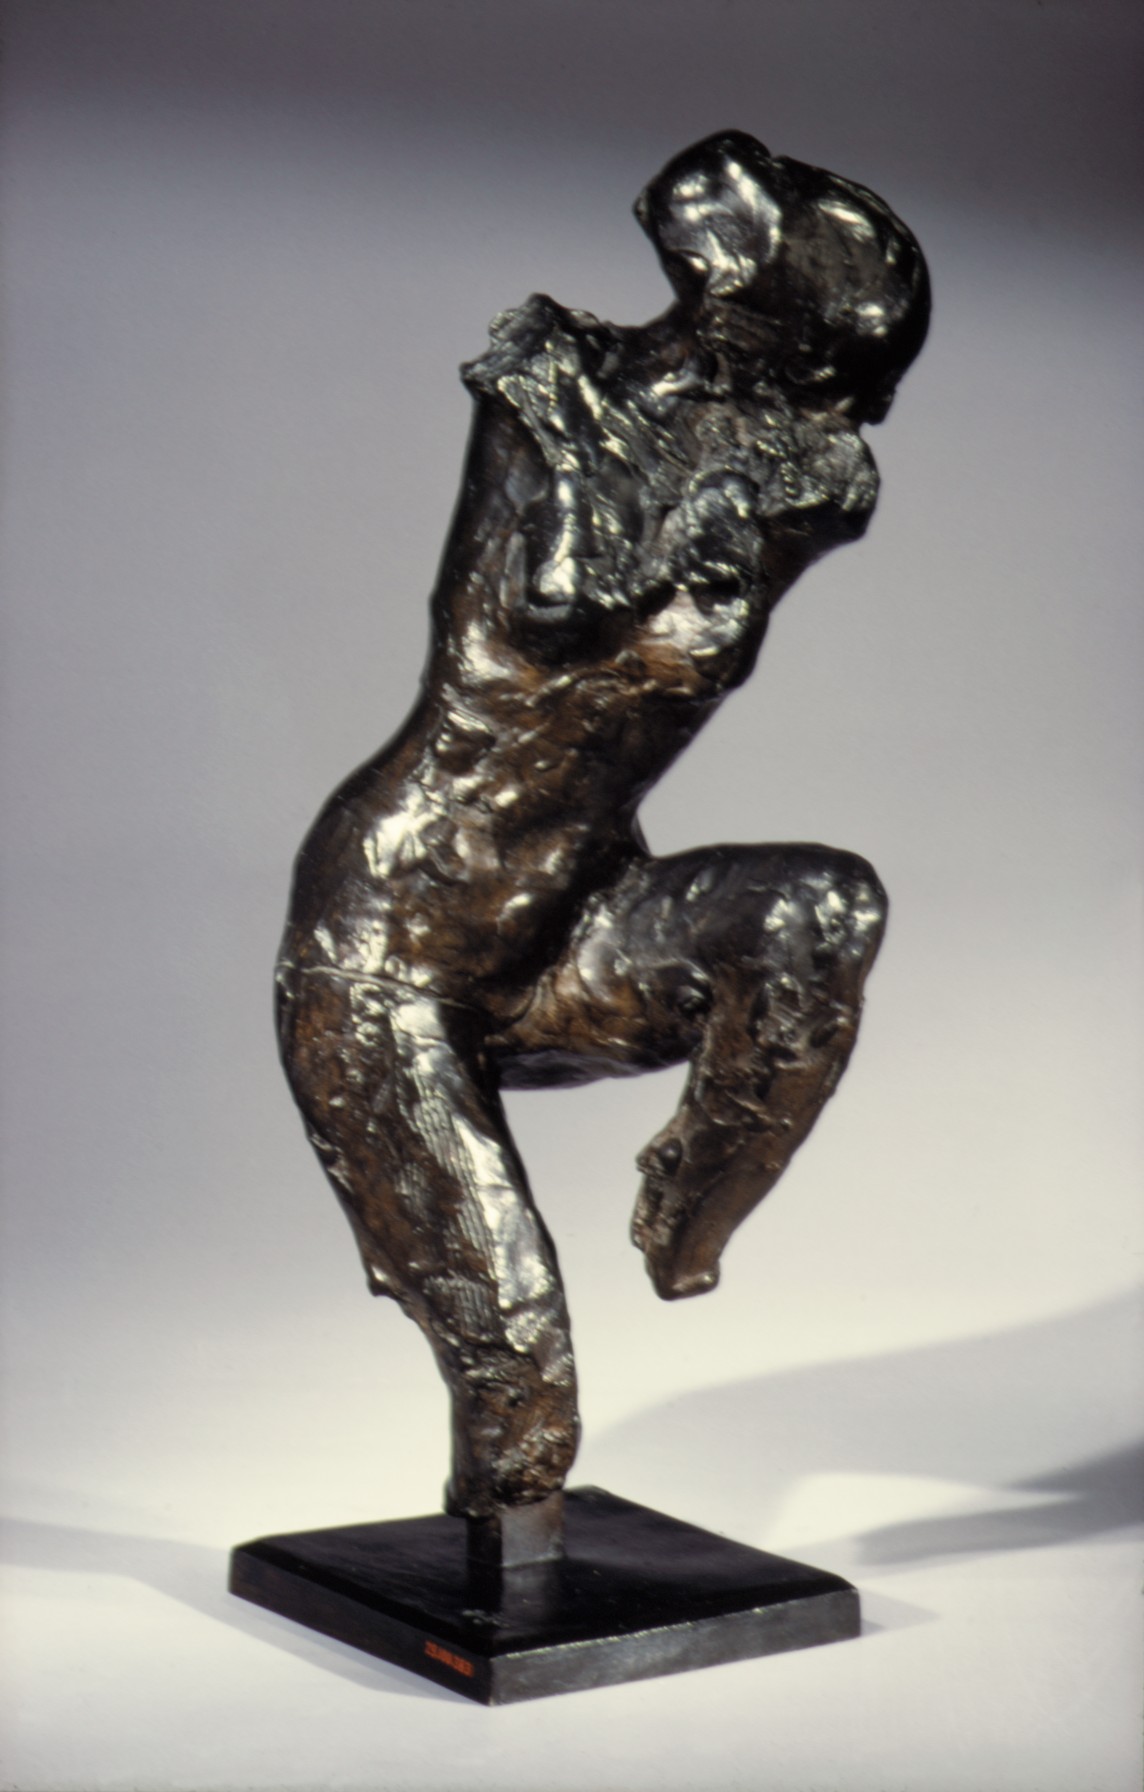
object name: statuette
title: Woman Getting out of the Bath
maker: edgar degas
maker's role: artist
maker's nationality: french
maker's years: 1834-1917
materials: bronze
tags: female nudes,bathing